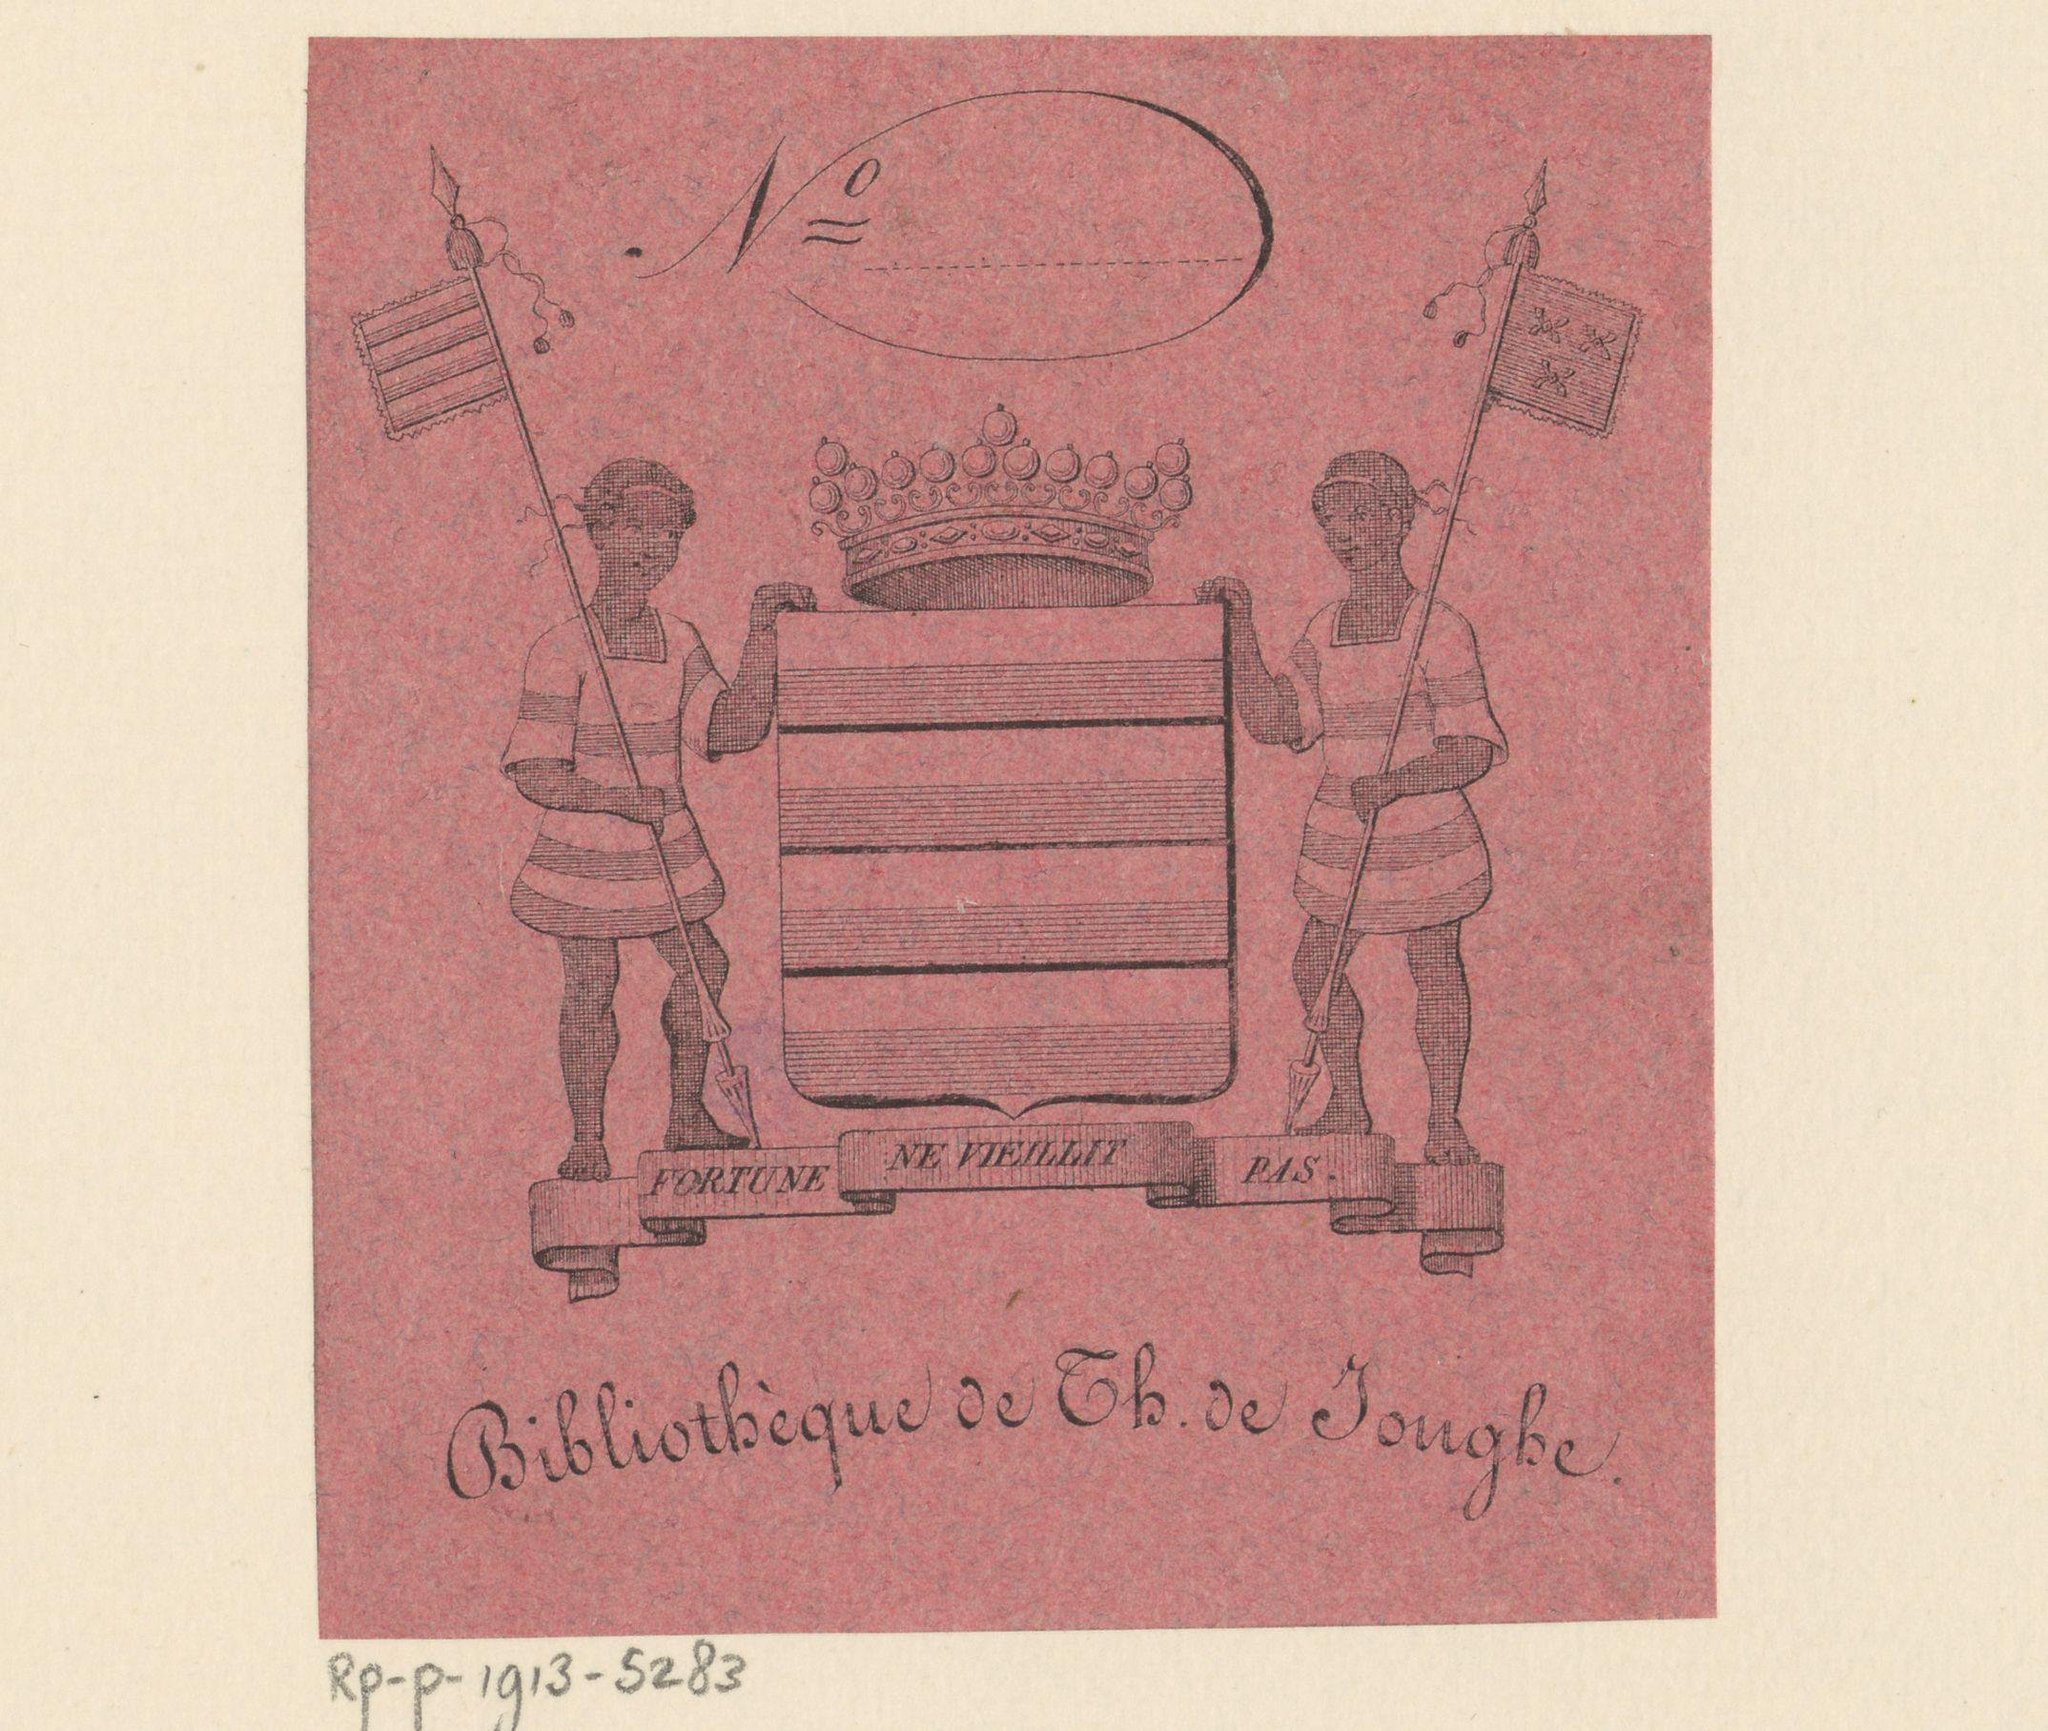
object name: bookplate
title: Fortune ne vieillit pas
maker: Anonymous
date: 1800-1899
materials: paper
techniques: etching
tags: armorial bearing, heraldry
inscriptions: collector's mark: Lugt 2233, collector's mark: Lugt 2760